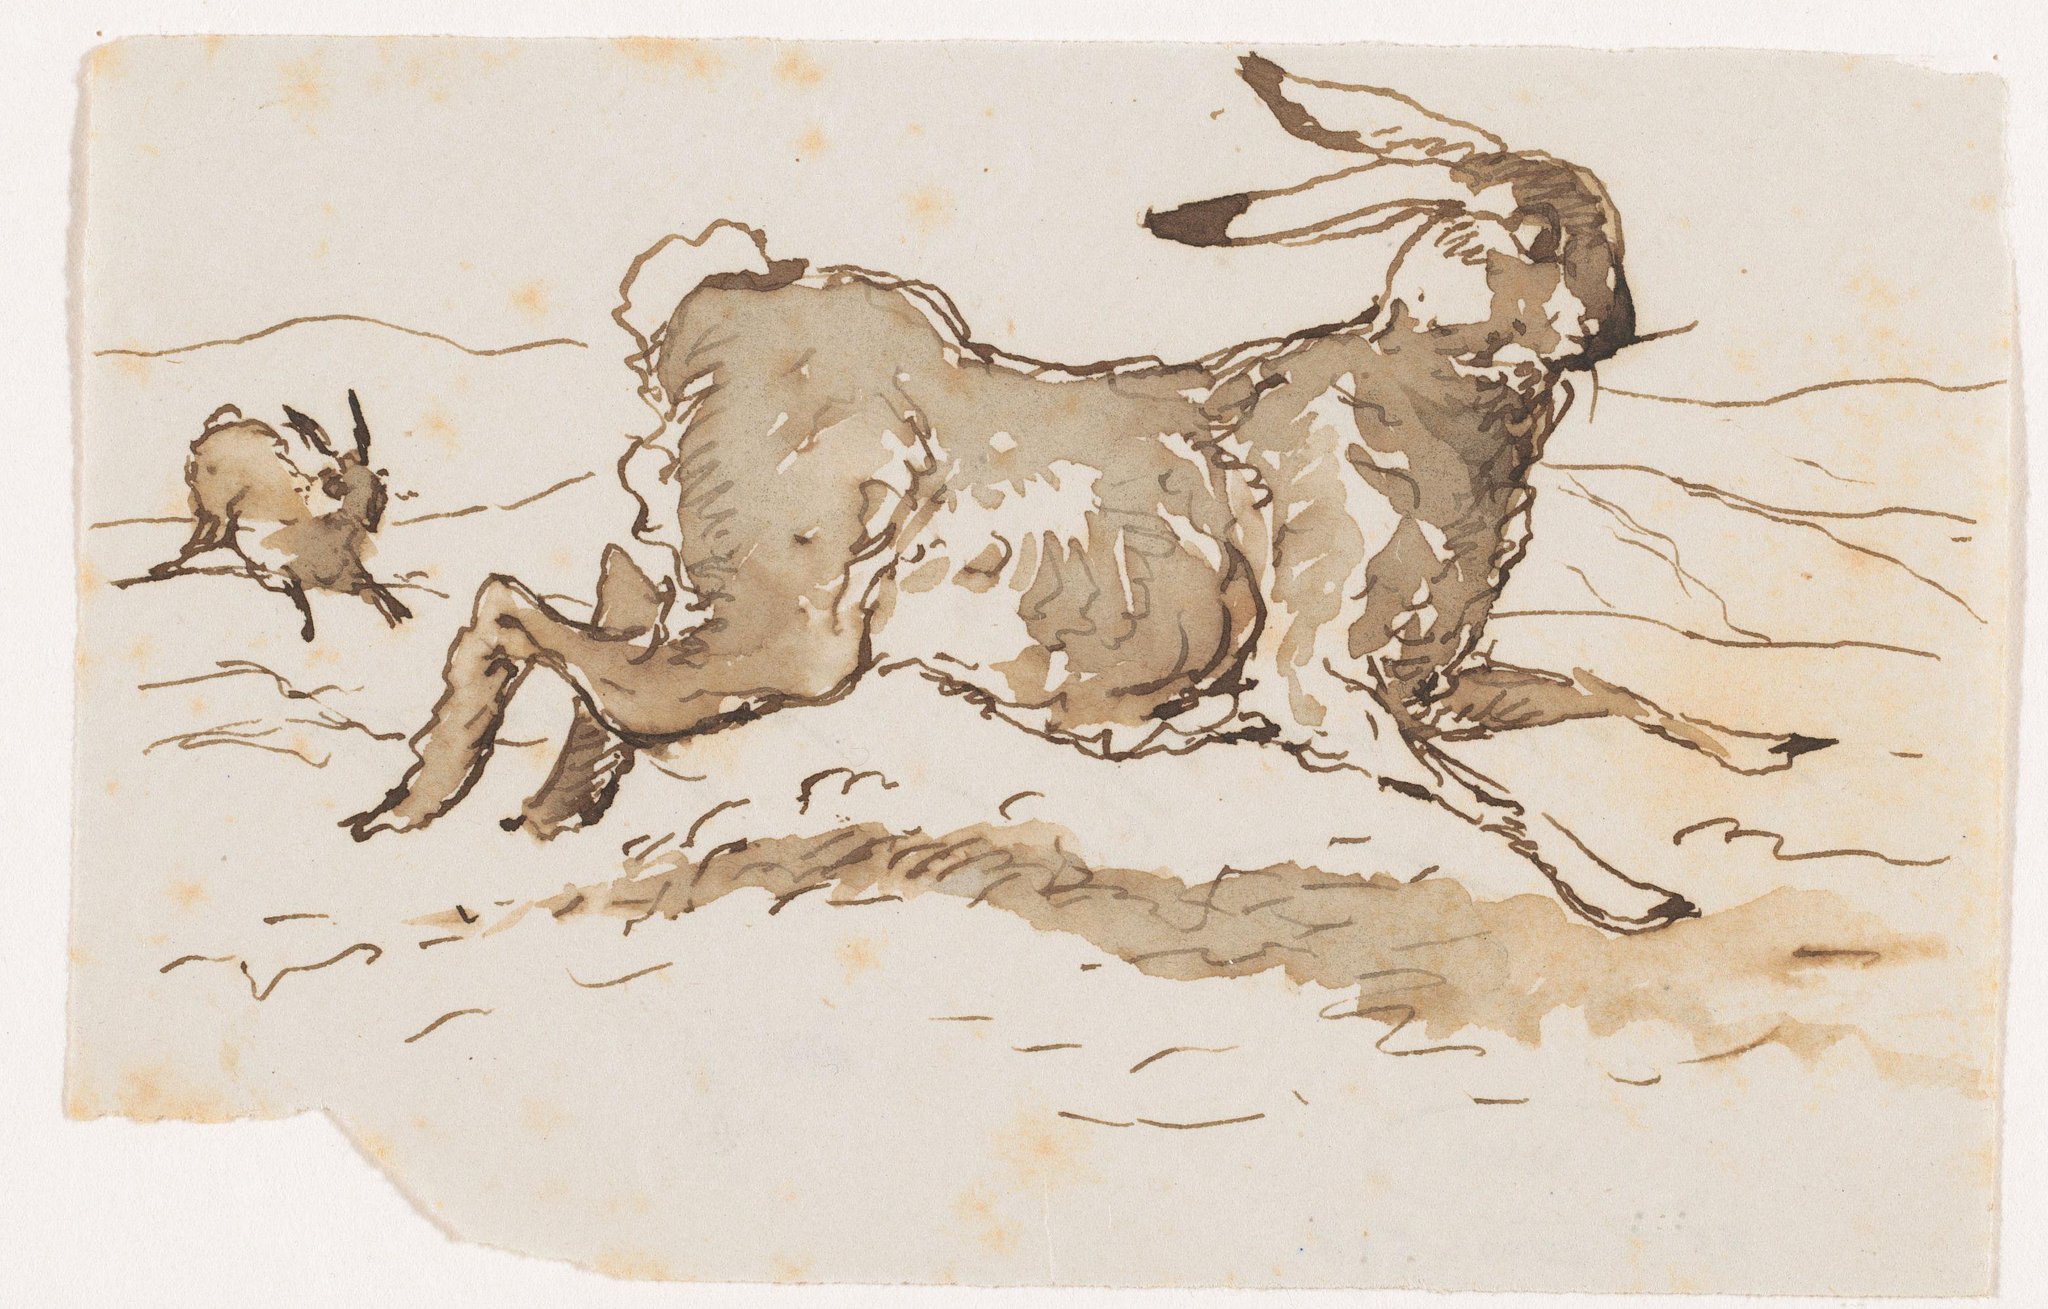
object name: drawing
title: Haas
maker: johannes tavenraat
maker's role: draughtsman, painter, print maker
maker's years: 1809-1881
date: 1840-1880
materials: ink, paper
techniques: brush, pen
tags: rodents: hare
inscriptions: collector's mark: Lugt 2228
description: Haas. Getekend op de achterzijde van een fragment van een brief gericht aan Tavenraat.